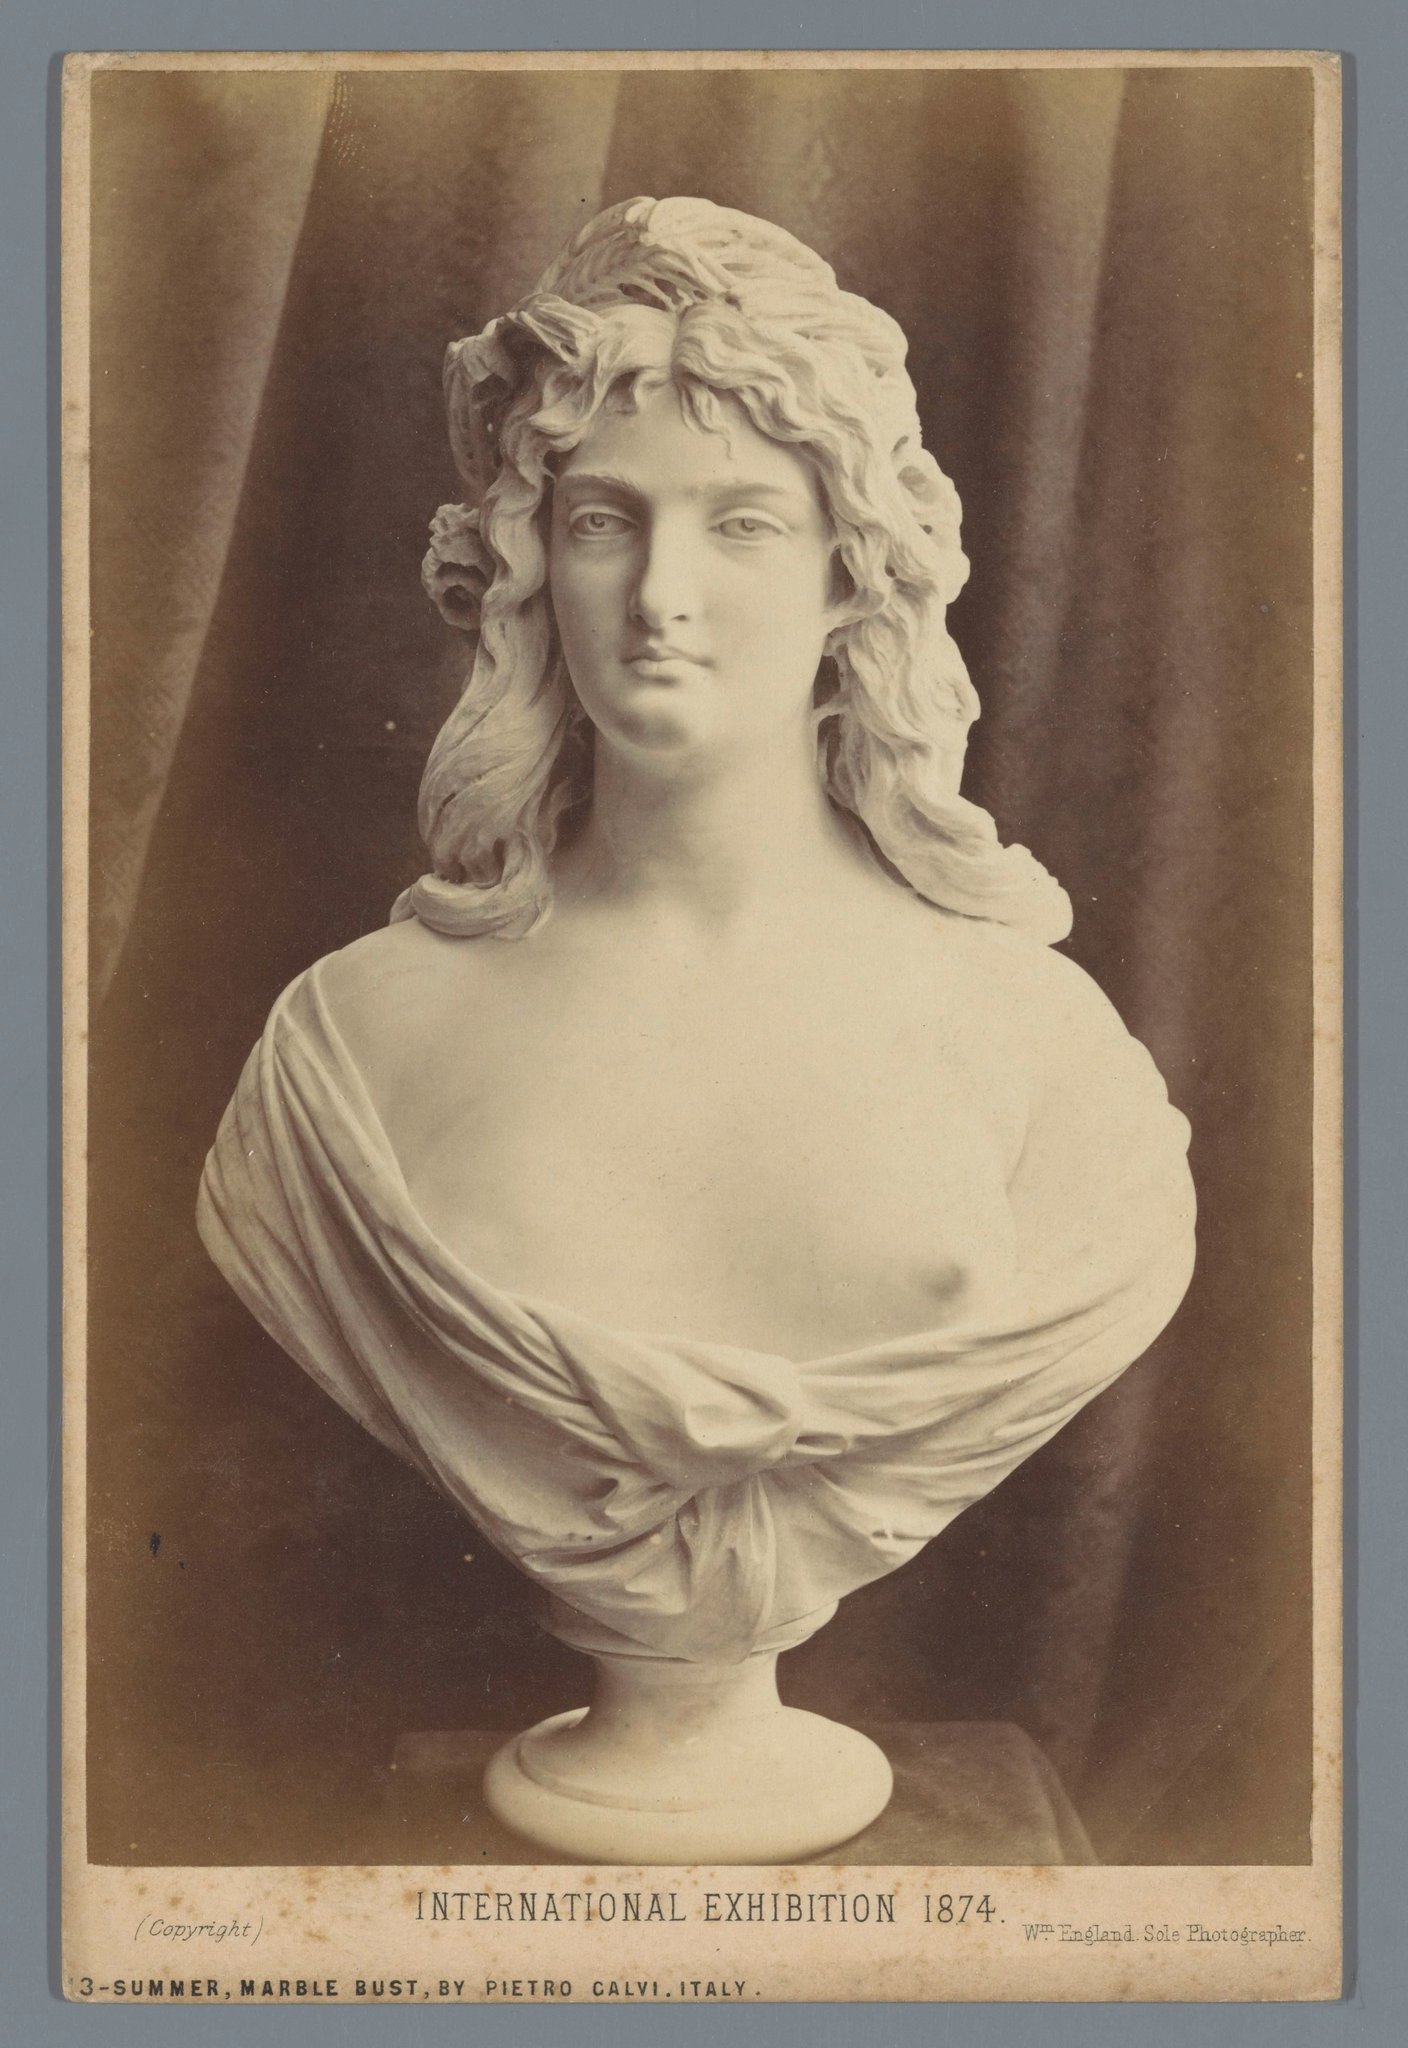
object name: cabinet photograph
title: International Exhibition 1874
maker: william england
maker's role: fotograaf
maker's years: 1816-1896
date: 1874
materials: cardboard, photographic support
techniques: albumen print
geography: london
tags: monument, statue, london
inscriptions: number: ‘60’, number: ‘13’